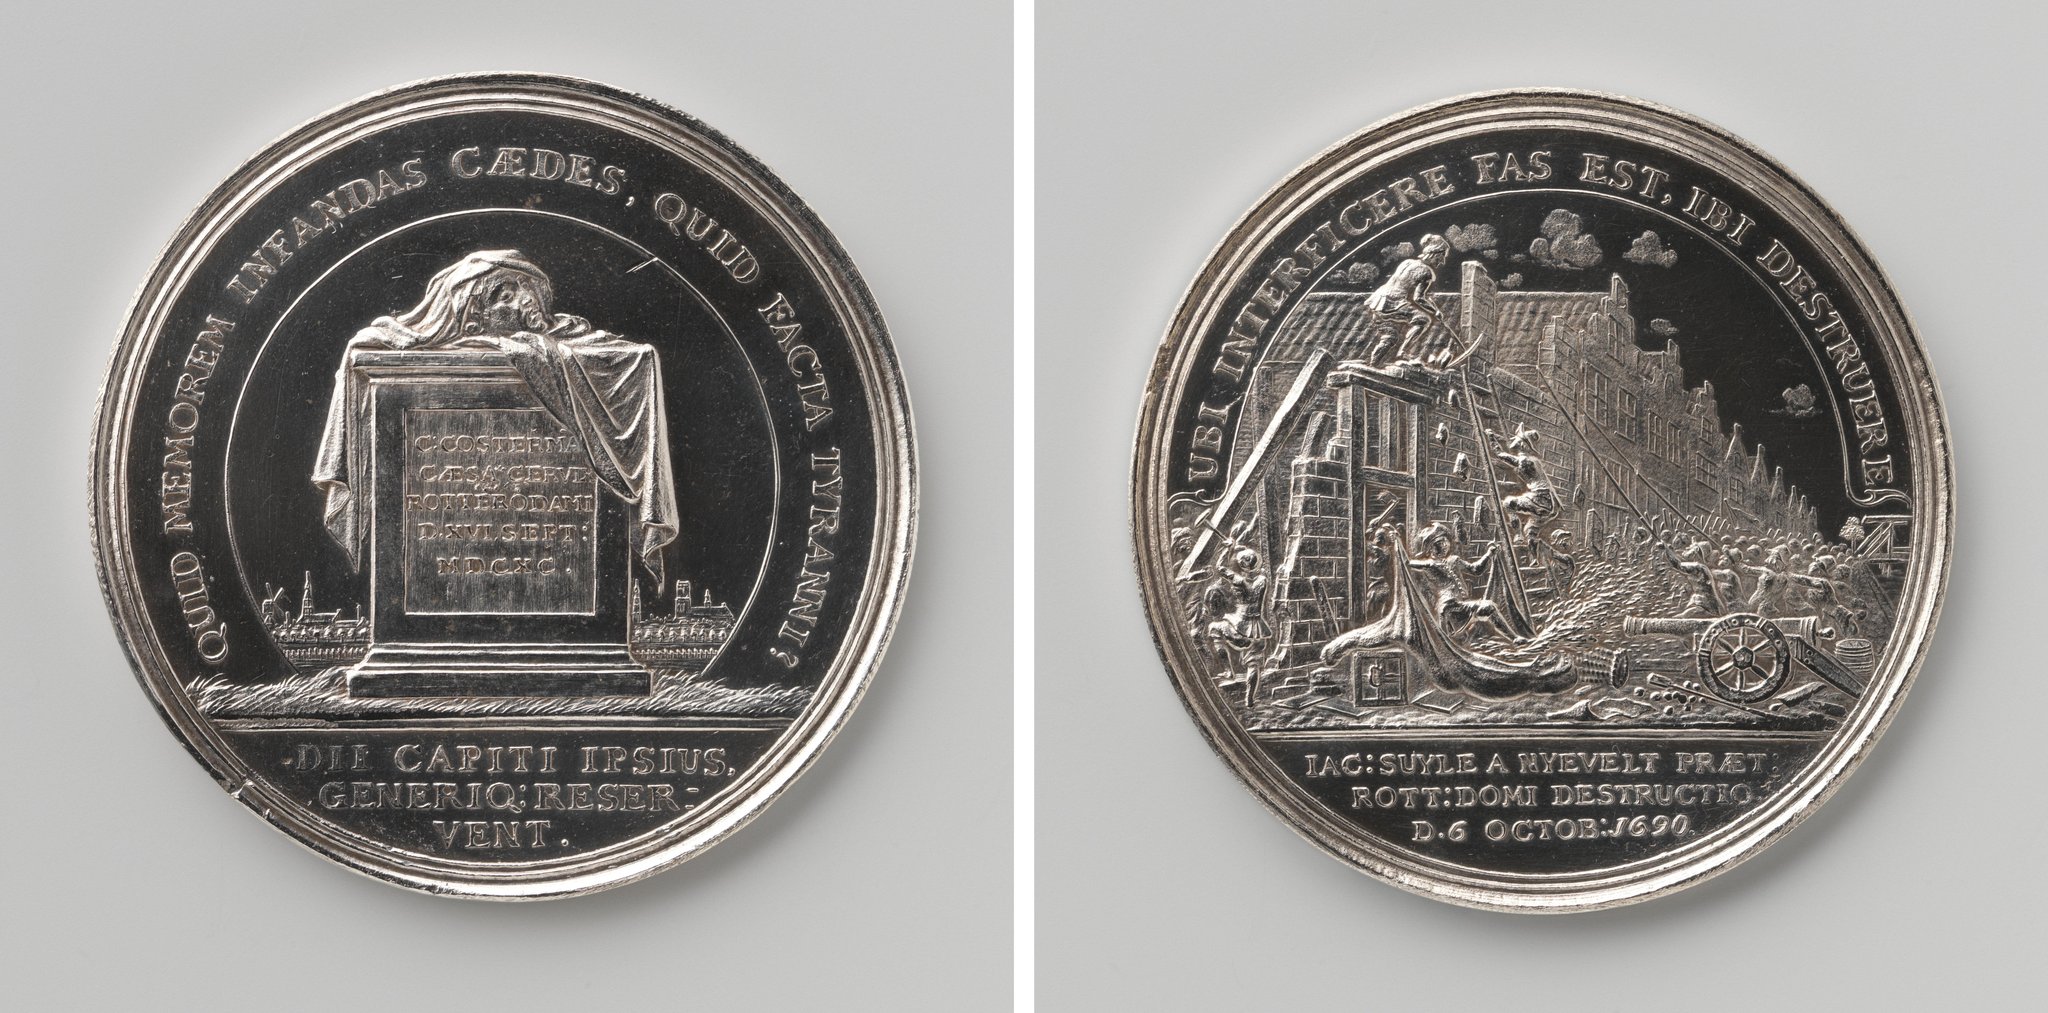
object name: satirical medal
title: Terechtstelling van schutter Cornelis Costerman en verwoesting van het huis van hoofdschout Jacob Zuylen van Nijevelt te Rotterdam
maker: jan smeltzing (i)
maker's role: modelleur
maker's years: 1656-1693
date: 1690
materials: silver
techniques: striking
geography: leiden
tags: rotterdam